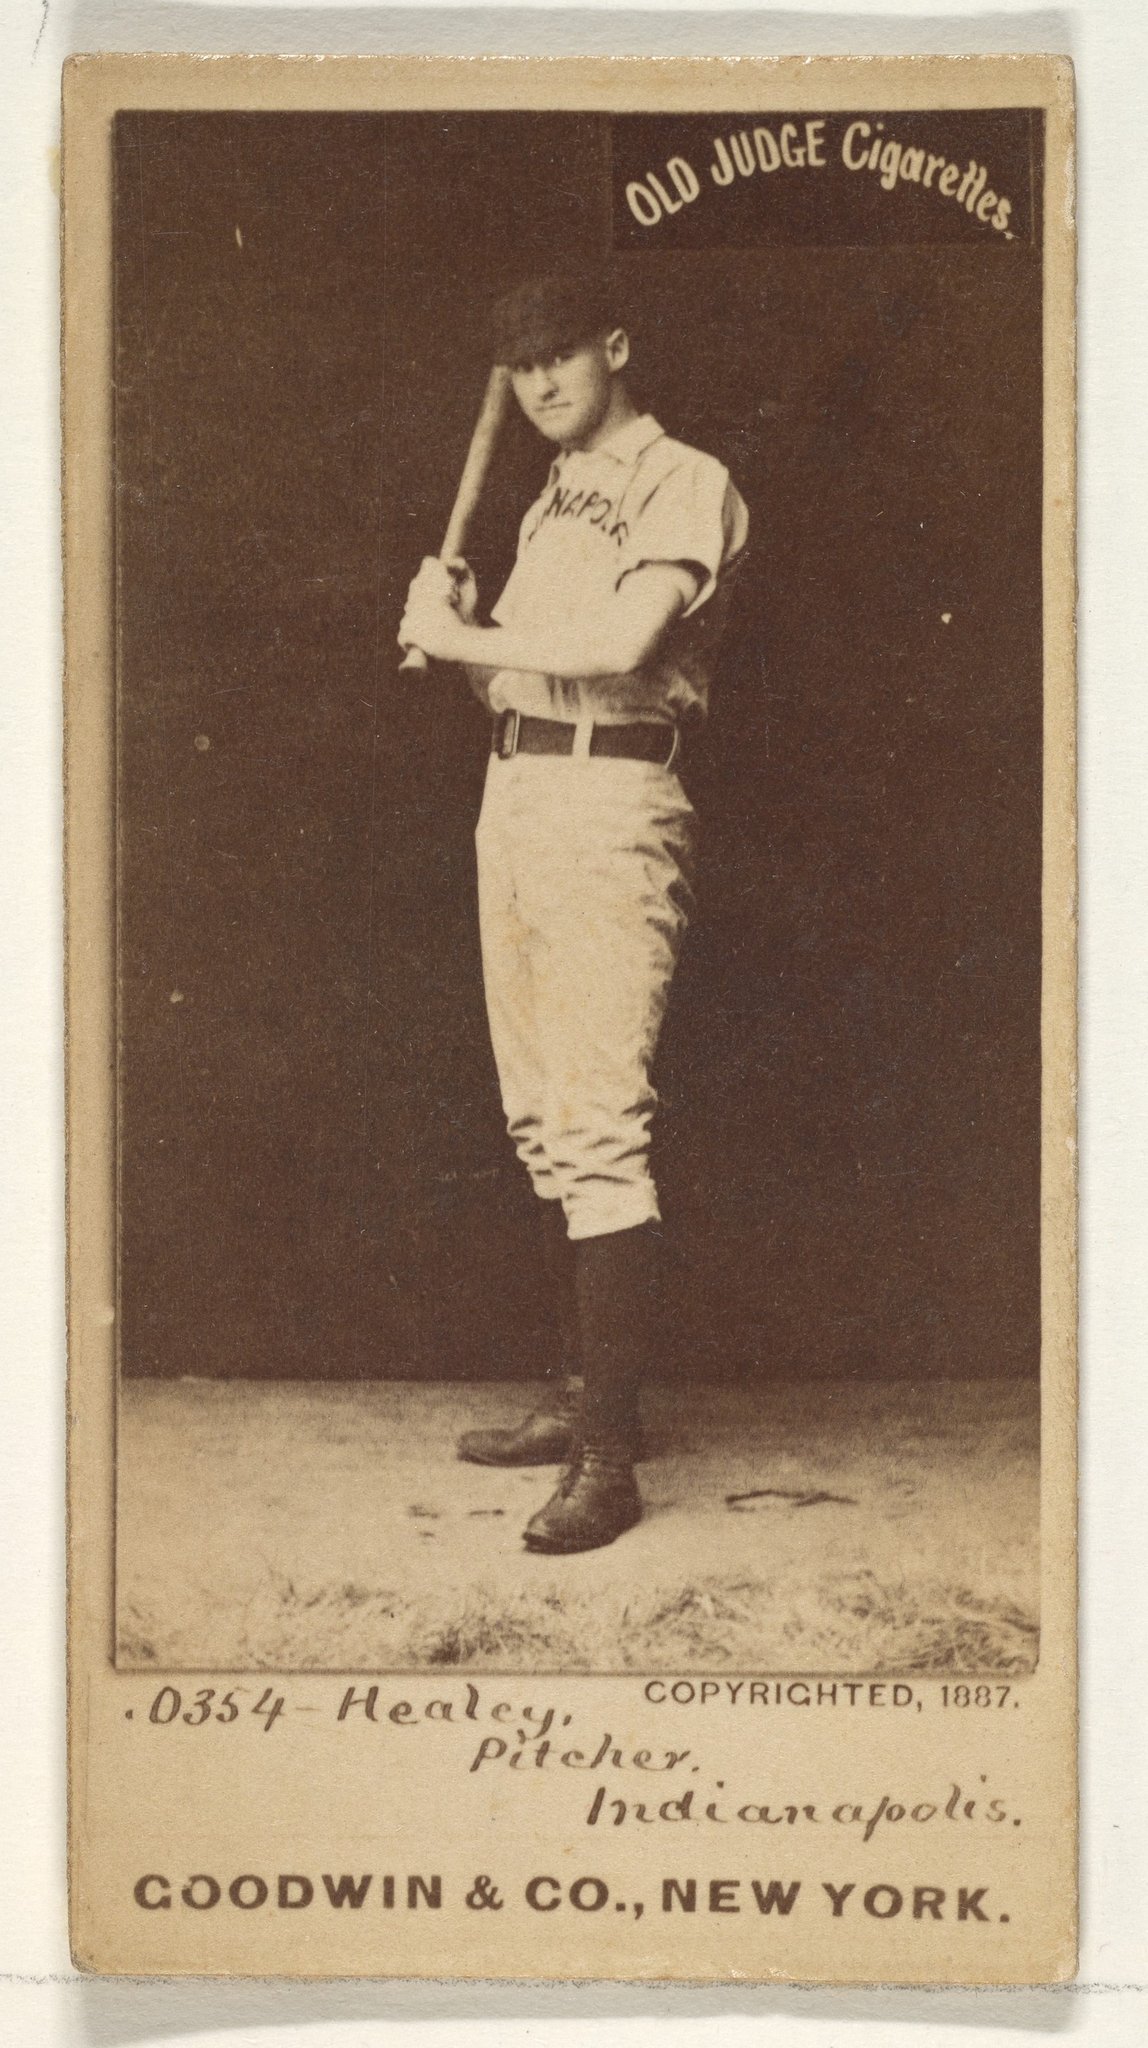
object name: baseball card, photograph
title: Healey, Pitcher, Indianapolis, from the Old Judge series (N172) for Old Judge Cigarettes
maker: goodwin & company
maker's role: publisher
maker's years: 1850-1950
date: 1887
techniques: albumen silver print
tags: men,portraits,baseball,athletes